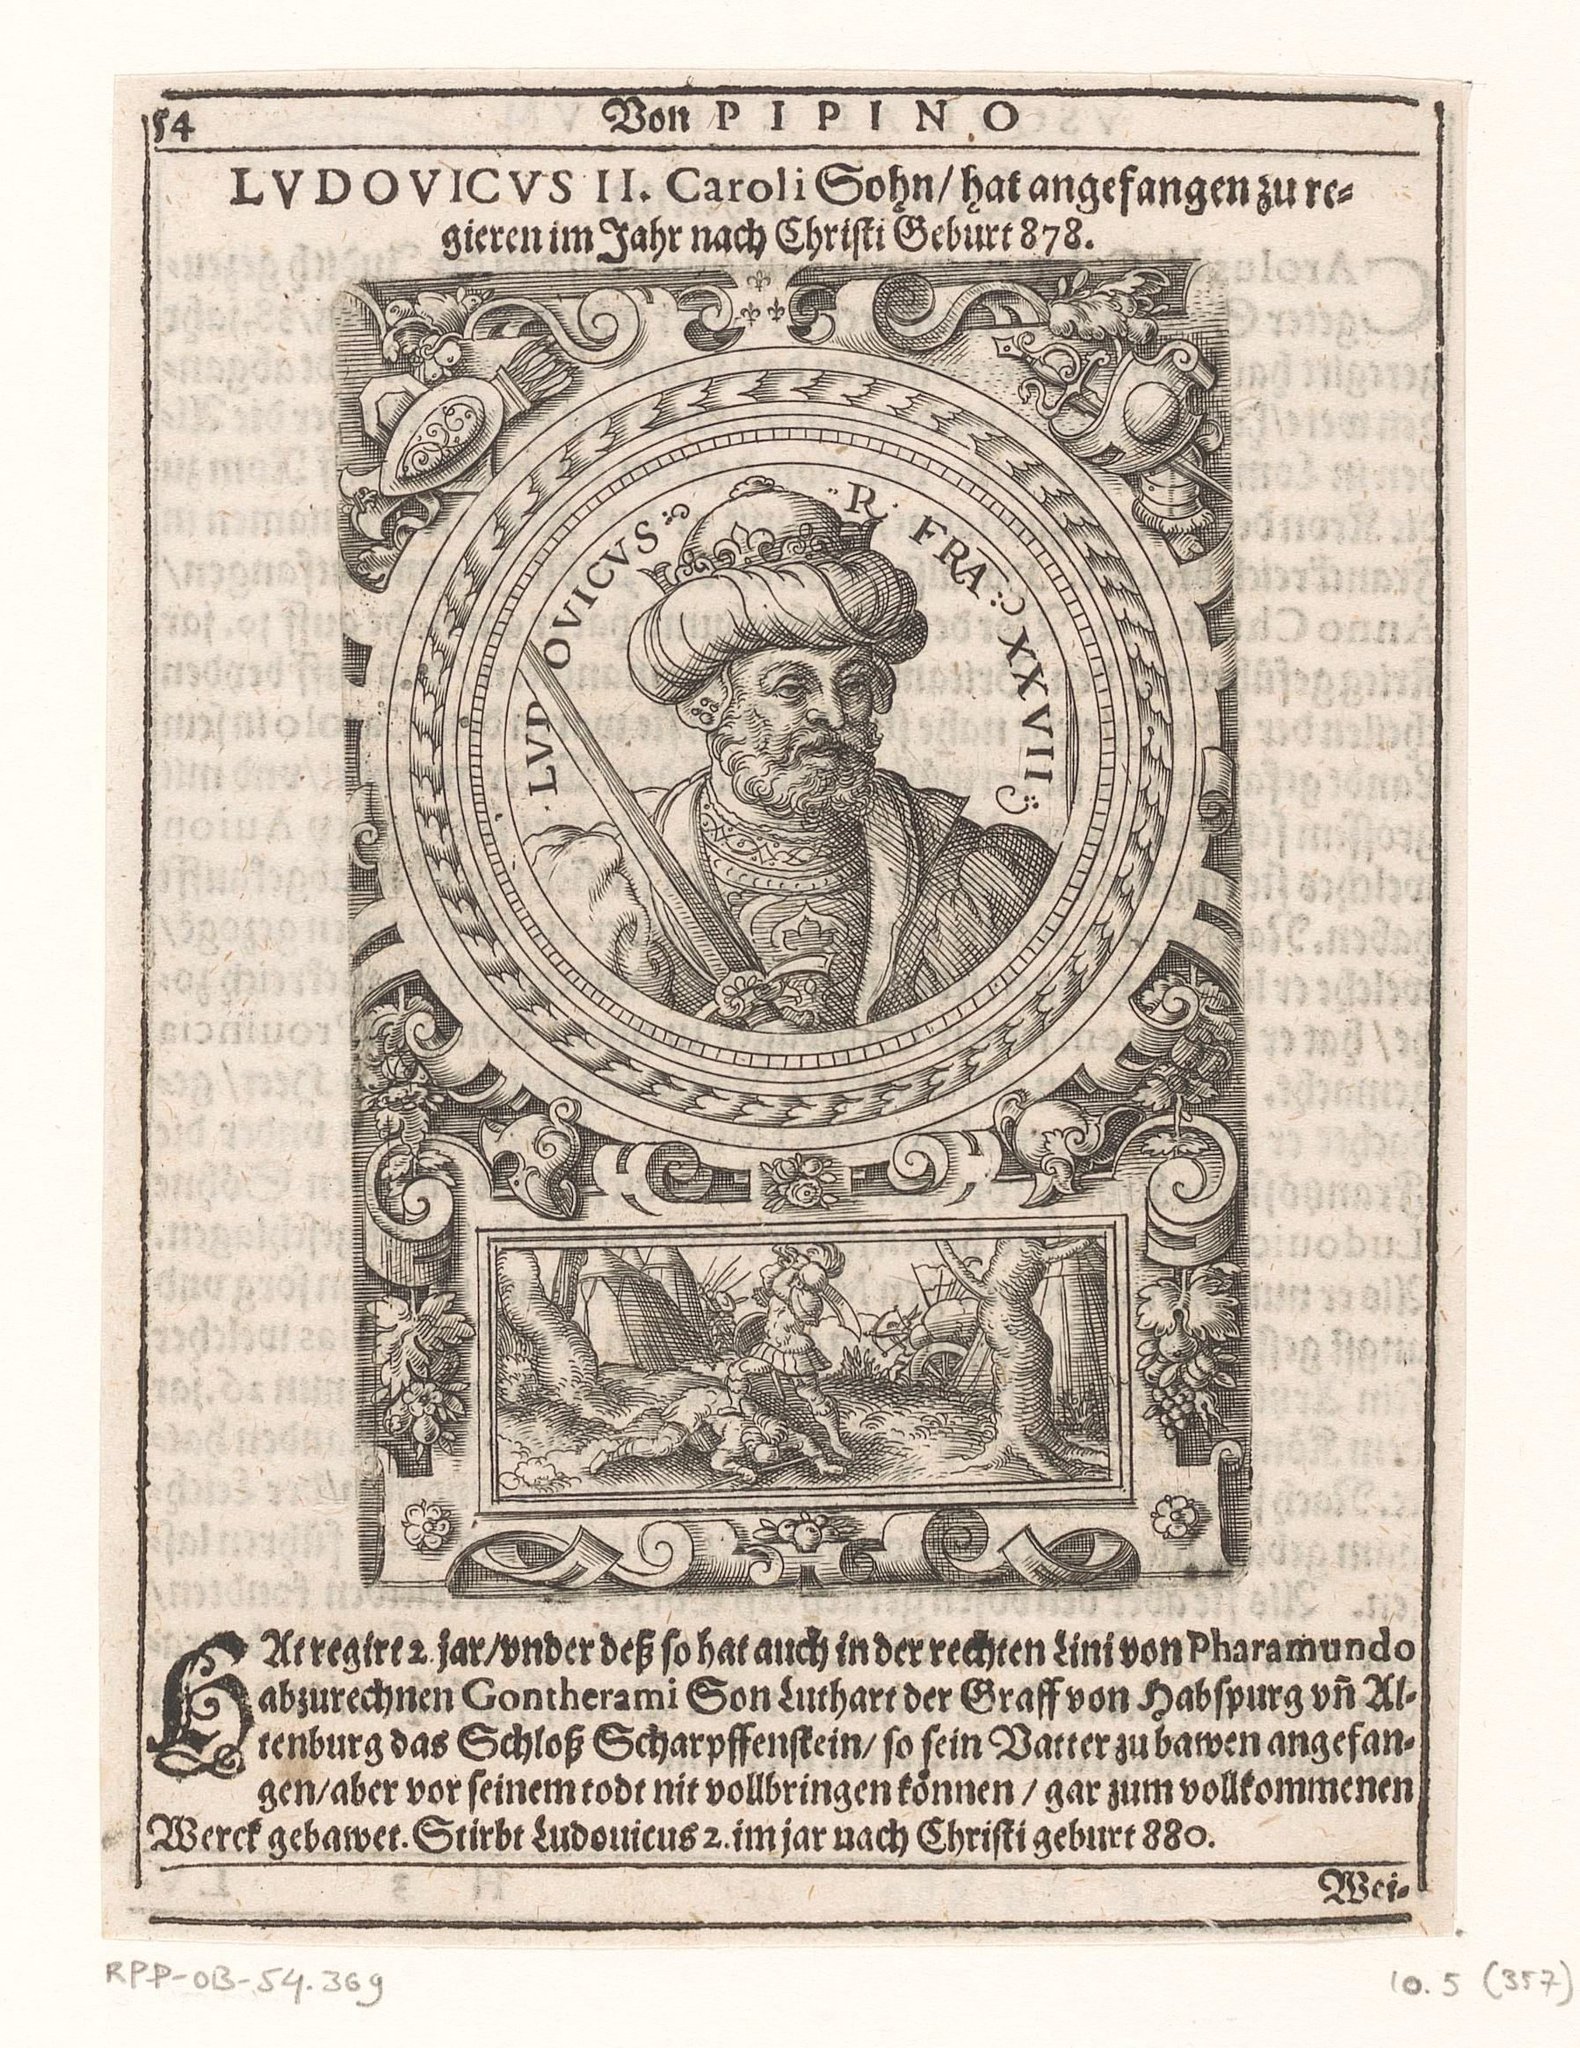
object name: print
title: Portret van Lodewijk II, de Stamelaar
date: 1598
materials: paper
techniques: engraving, etching, intaglio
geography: nuremberg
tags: scrollwork, strapwork ~ ornament, historical persons, ruler, sovereign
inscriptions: collector's mark: Lugt 2228, number: ‘158’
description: Prent afkomstig uit de publicatie: Michael Eizinger. Könige in Frankreich. Keulen: Johann Bussemacher, 1598, p. 54. De publicatie bevat prenten van Jost Amman en Virgil Solis.